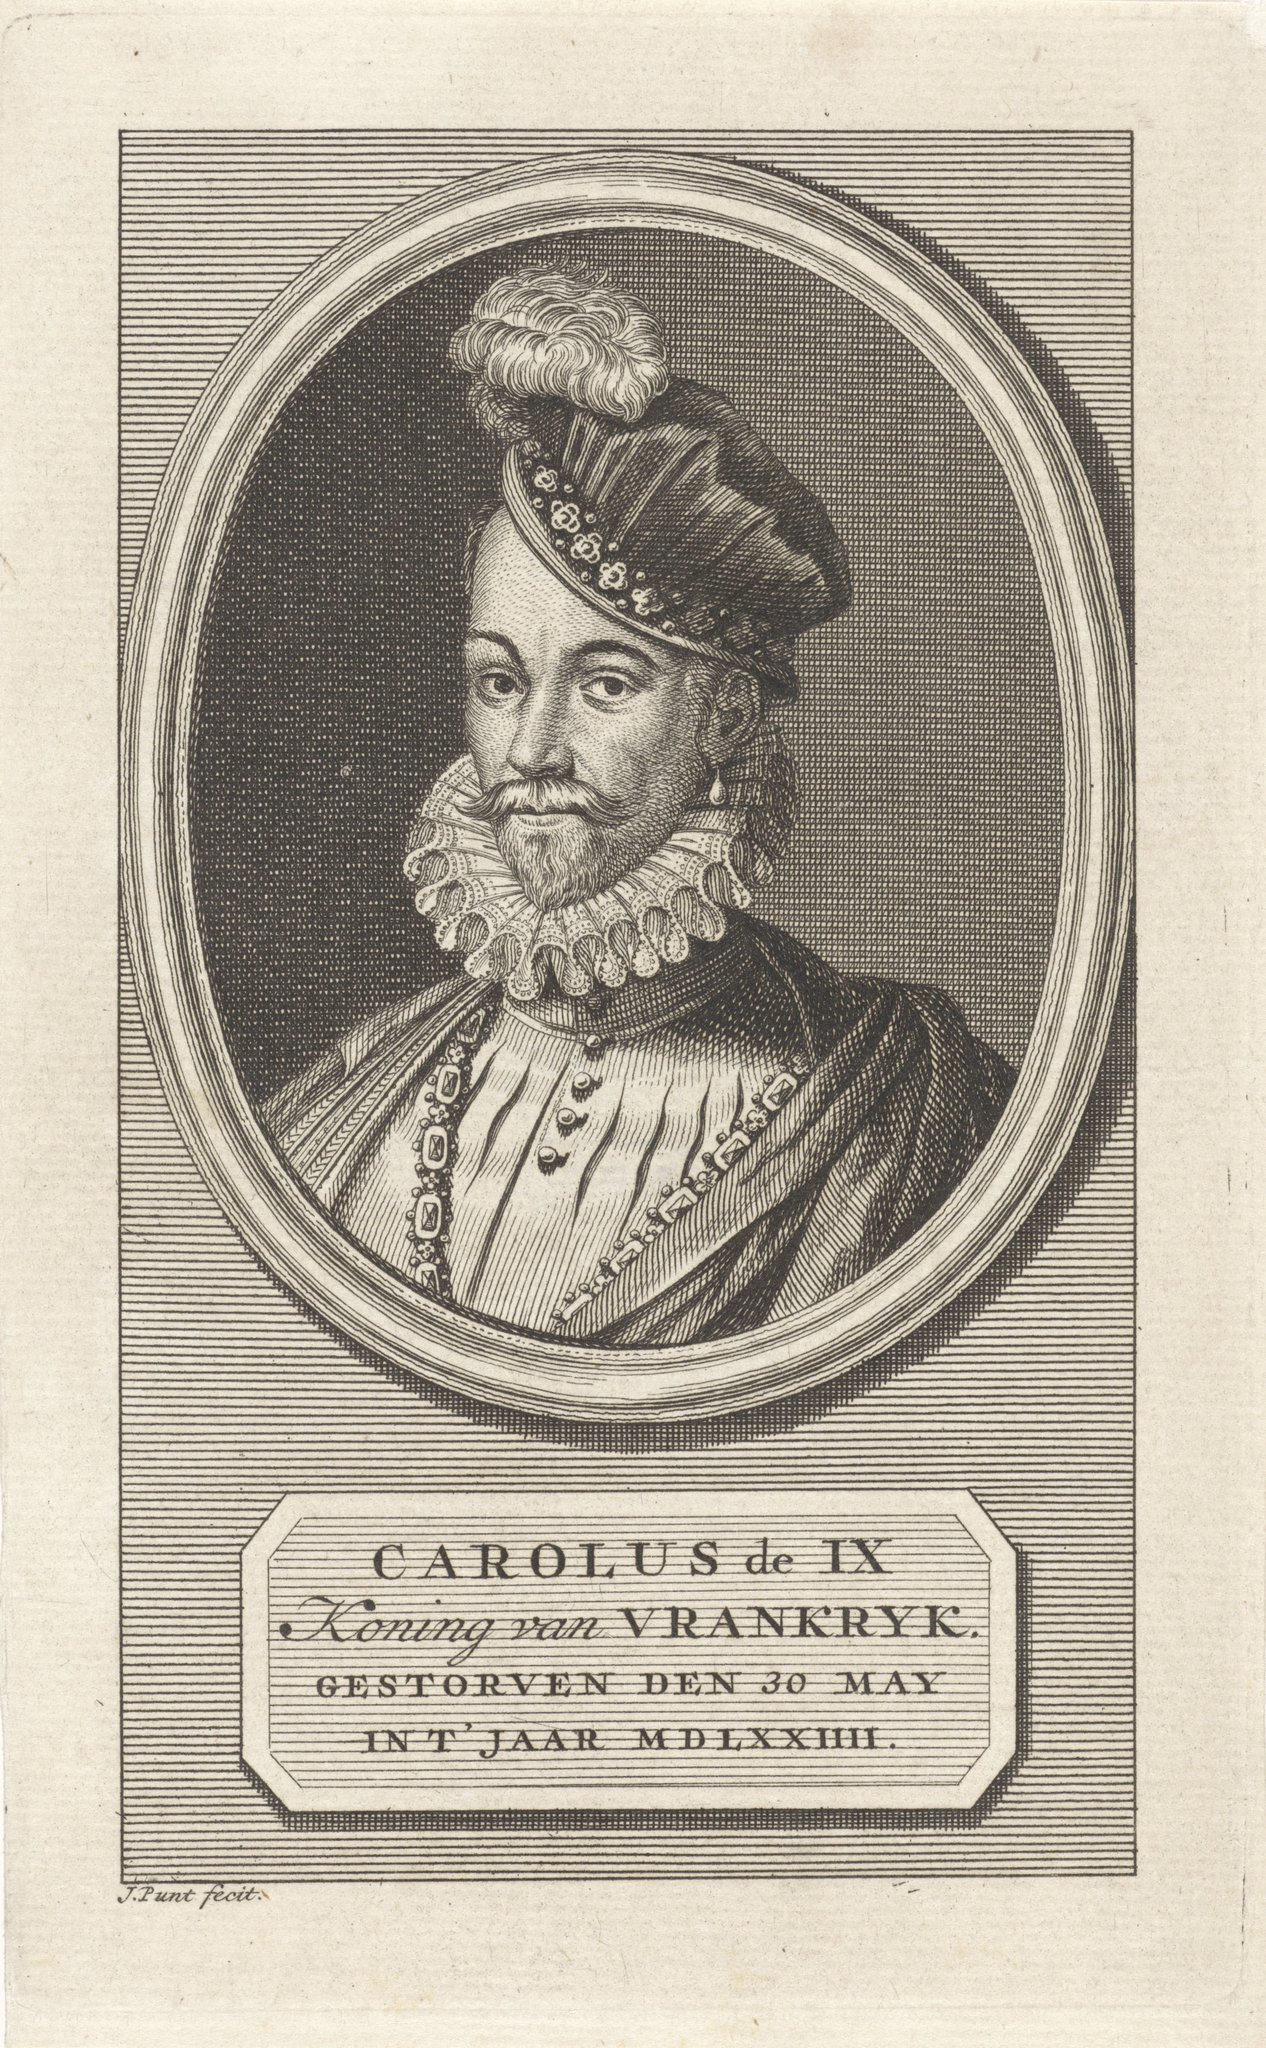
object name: book illustration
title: Portret van Karel IX, koning van Frankrijk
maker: jan punt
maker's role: draughtsman, print maker, publisher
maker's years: 1711-1779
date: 1786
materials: paper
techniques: engraving, etching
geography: northern netherlands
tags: karel ix (koning van frankrijk)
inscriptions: collector's mark: Lugt 2228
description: Prent gebruikt als illustratie in: Meteren, Emanuel van. Oorlogen en geschiedenissen der Nederlanderen en derzelver nabuuren, deel I, p. 214. Amsterdam: Steven Jacobus Baalde, 1786.